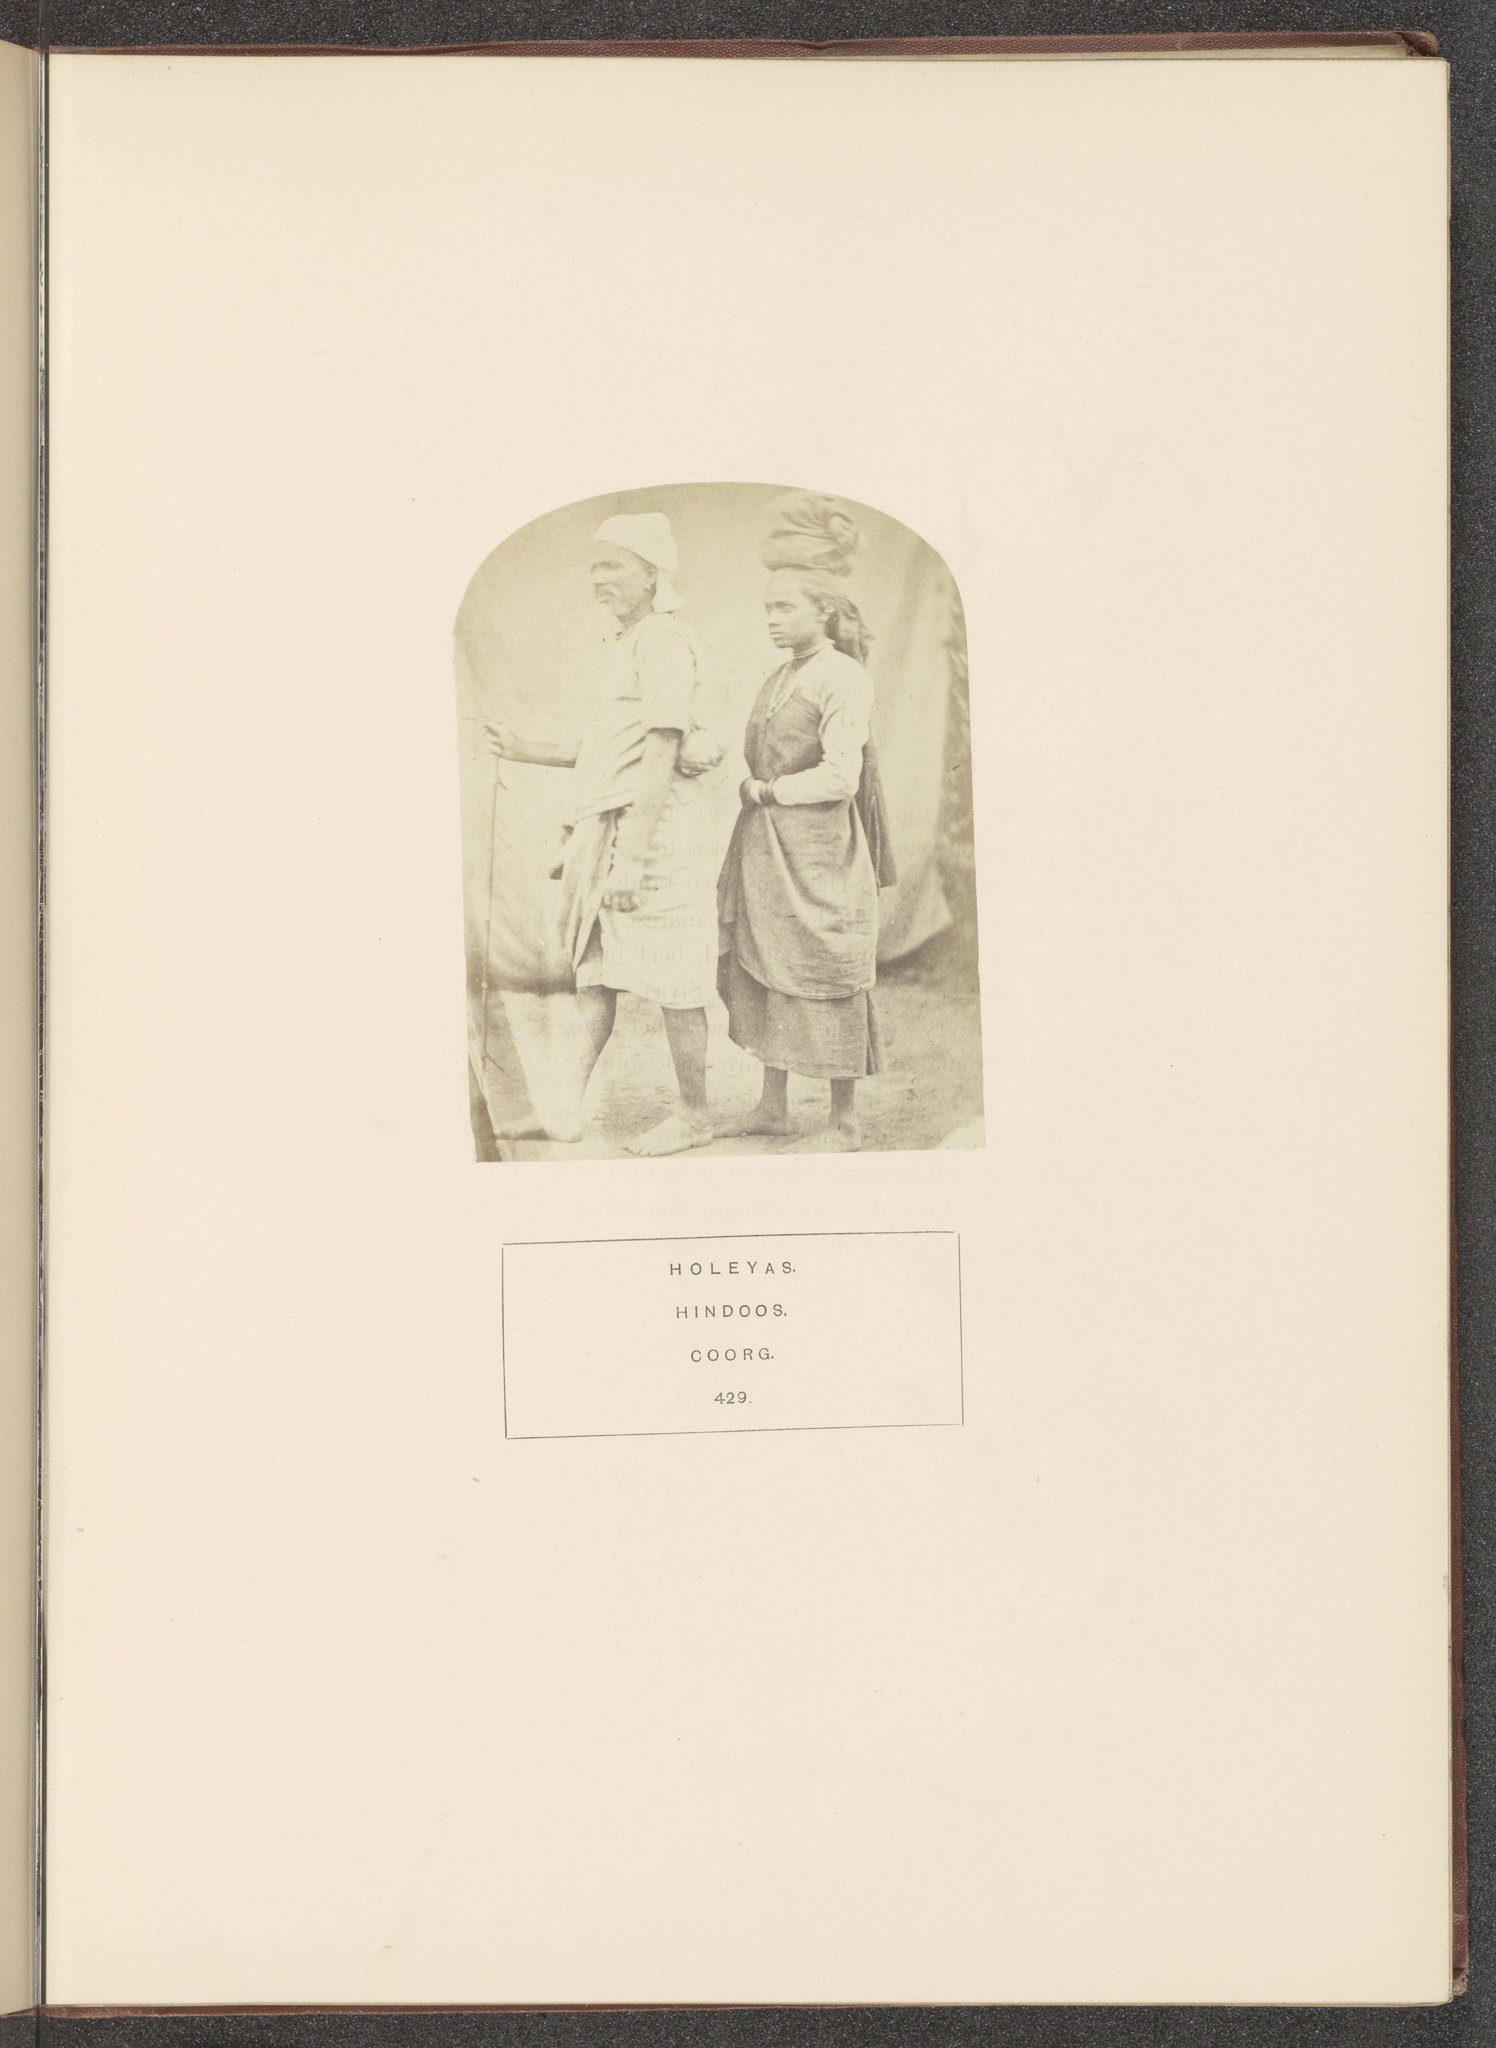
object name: photograph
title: Portrait of an unknown man and woman from the Holeya community of Kodagu, Karnataka, India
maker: g. richter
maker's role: fotograaf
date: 1865-1875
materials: photographic support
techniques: albumen print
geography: kodagu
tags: human races; peoples; nationalities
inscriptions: inscription: ‘HOLEYAS./ HINDOOS./ COORG.’, number: ‘429.’